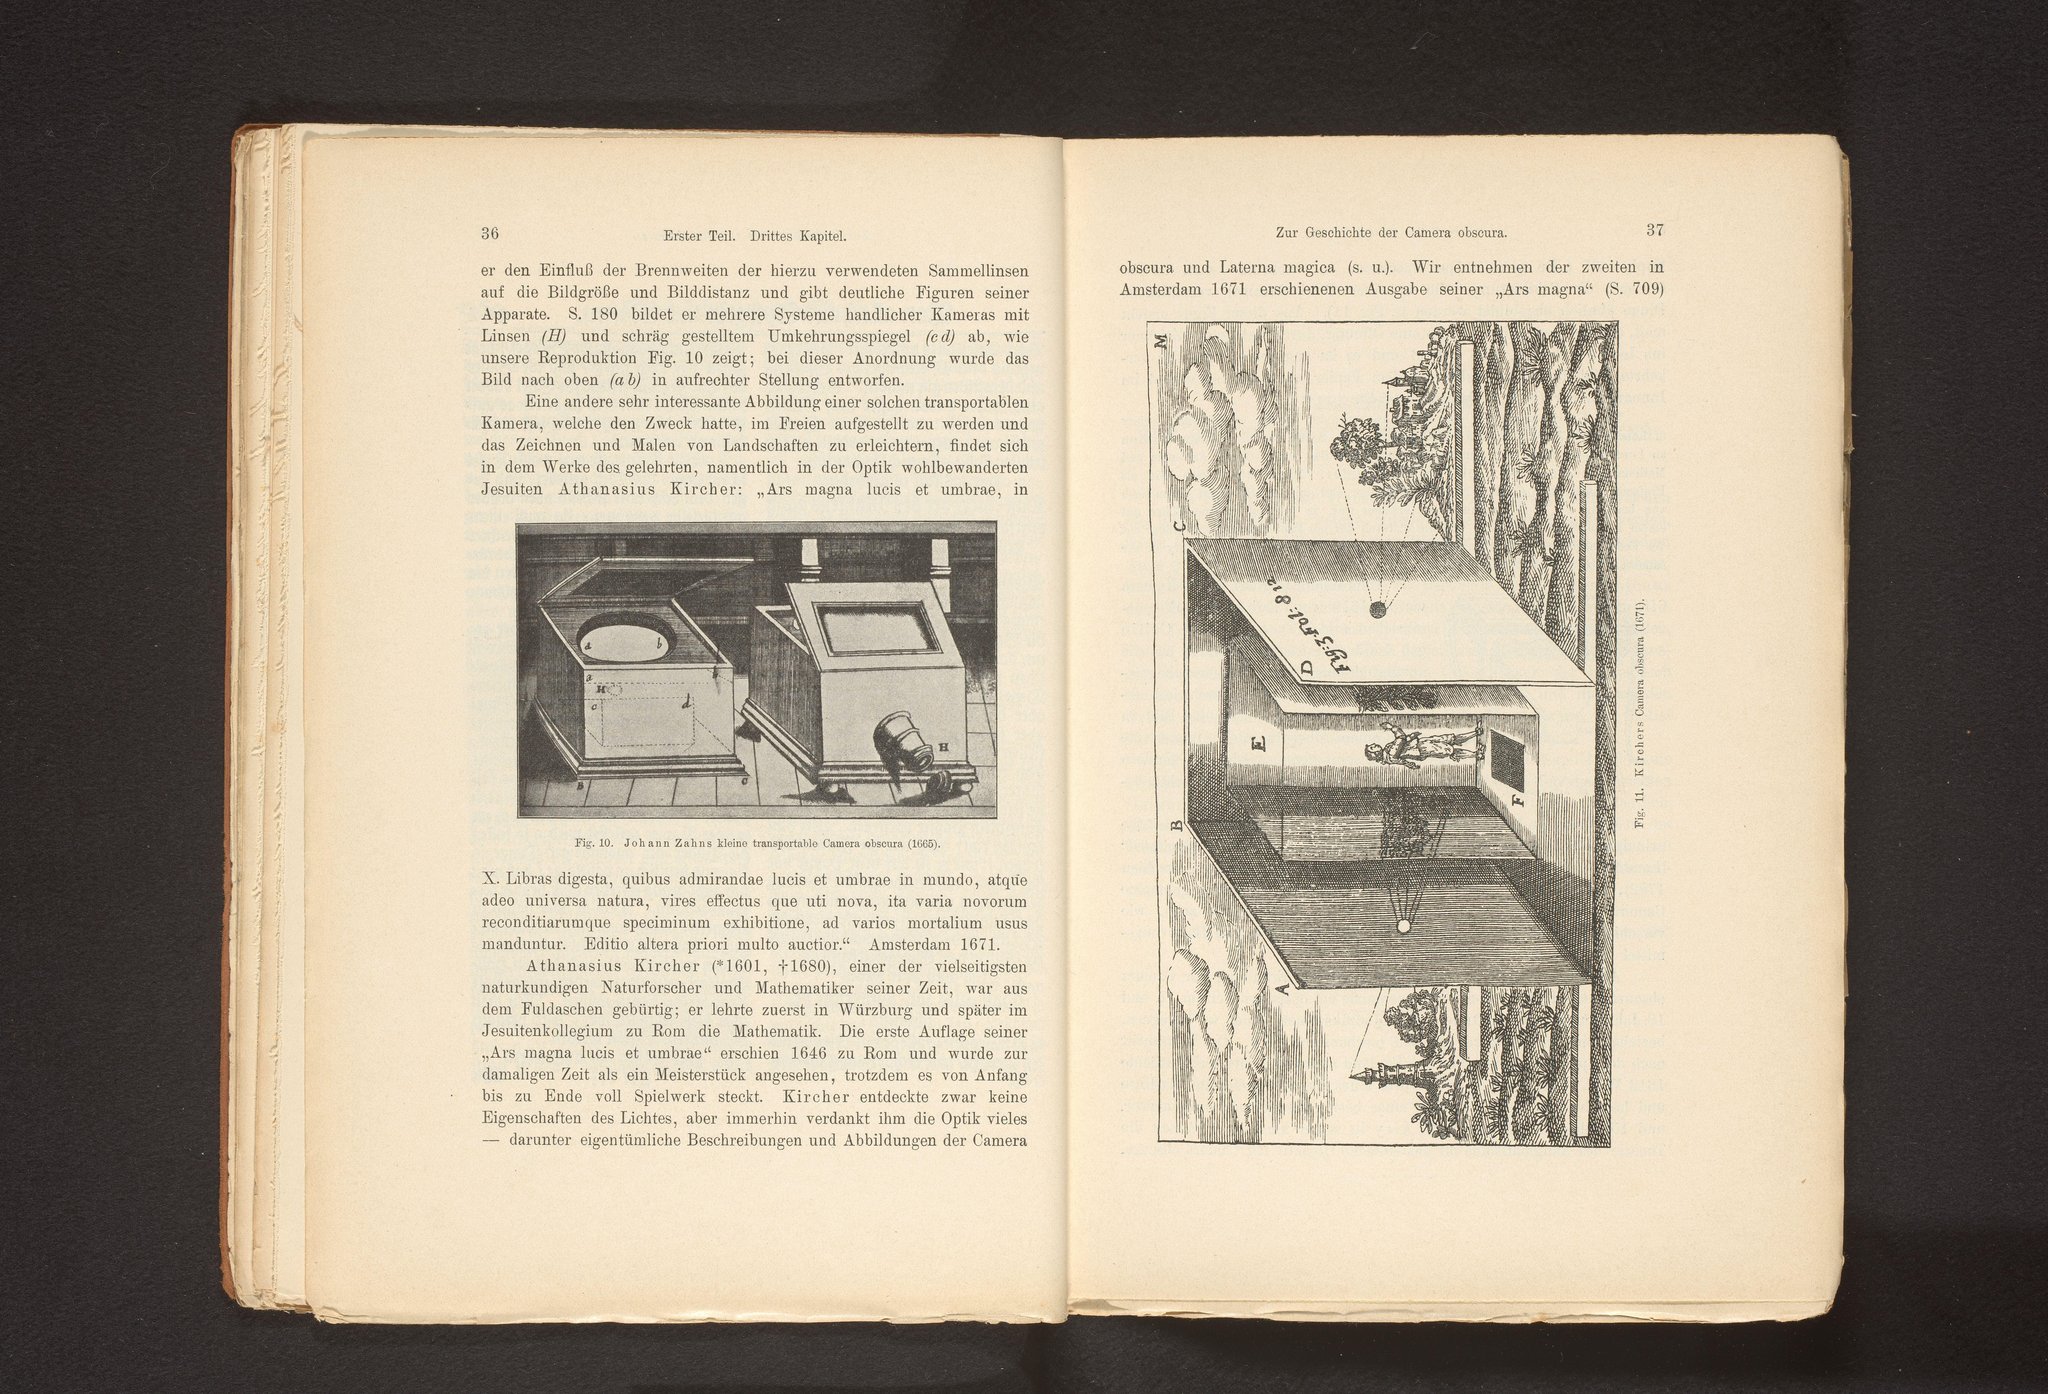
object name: page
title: Johann Zahns kleine transportable Camera obscura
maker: Anonymous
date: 1900-1905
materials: paper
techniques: autotype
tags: 'camera obscura' (~ tools, implements of draughtsman)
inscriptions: number: ‘Fig. 10.’